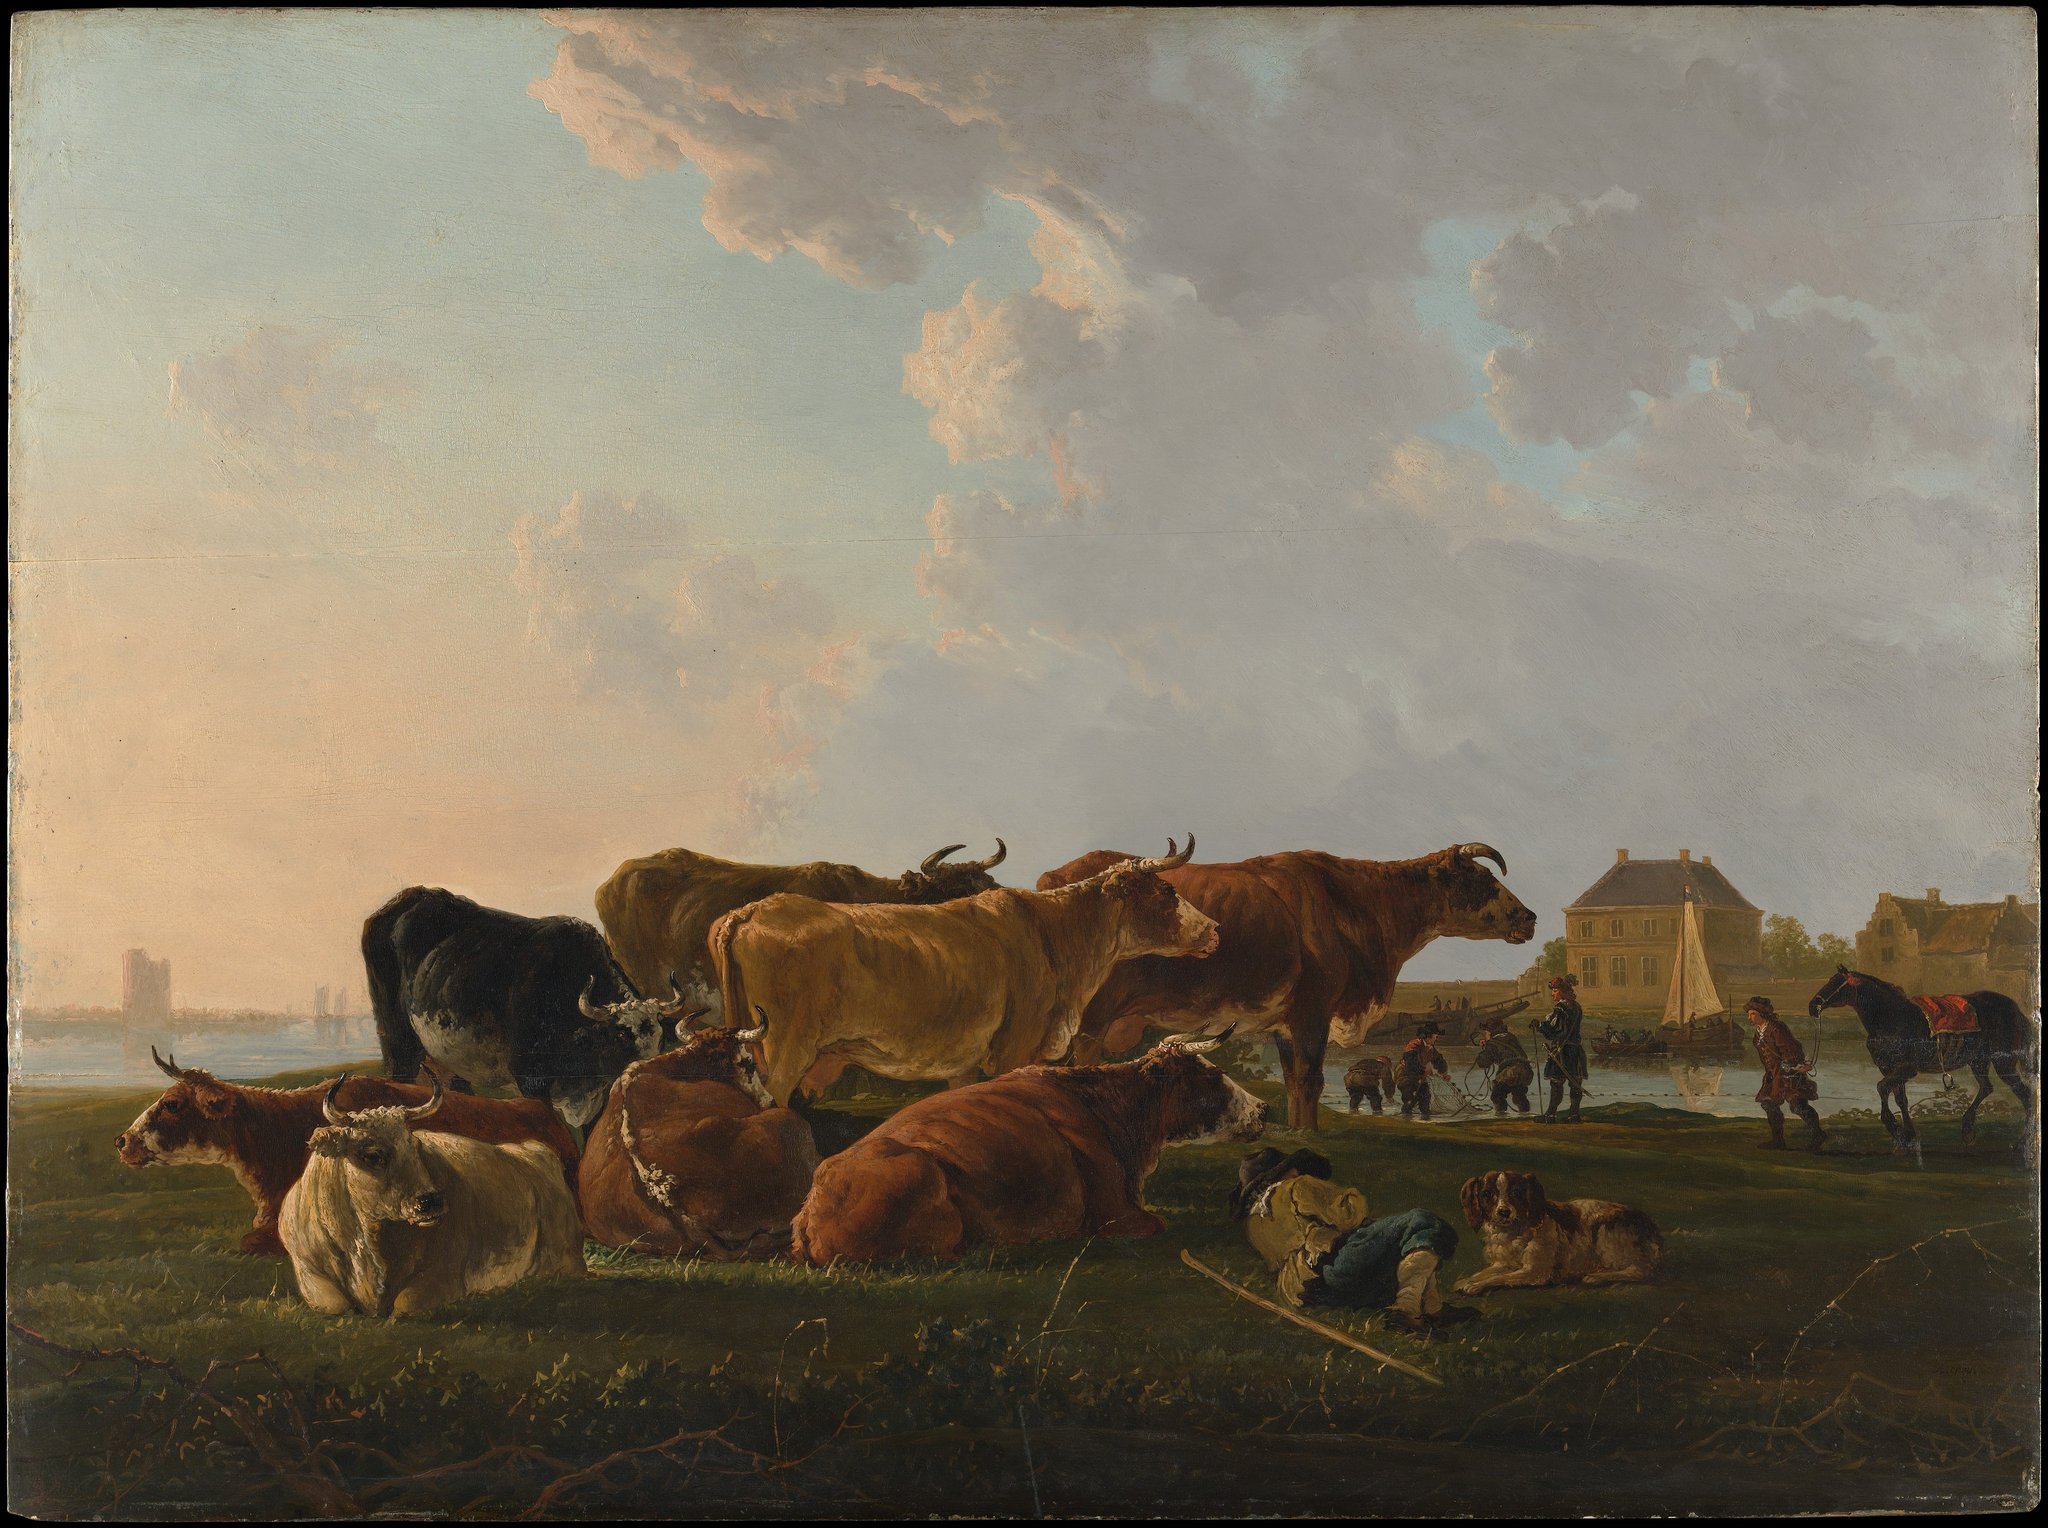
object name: painting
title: Landscape with Cattle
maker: jacob van strij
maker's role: artist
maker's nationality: dutch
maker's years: 1756-1815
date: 1800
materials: oil, wood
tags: cows,landscapes